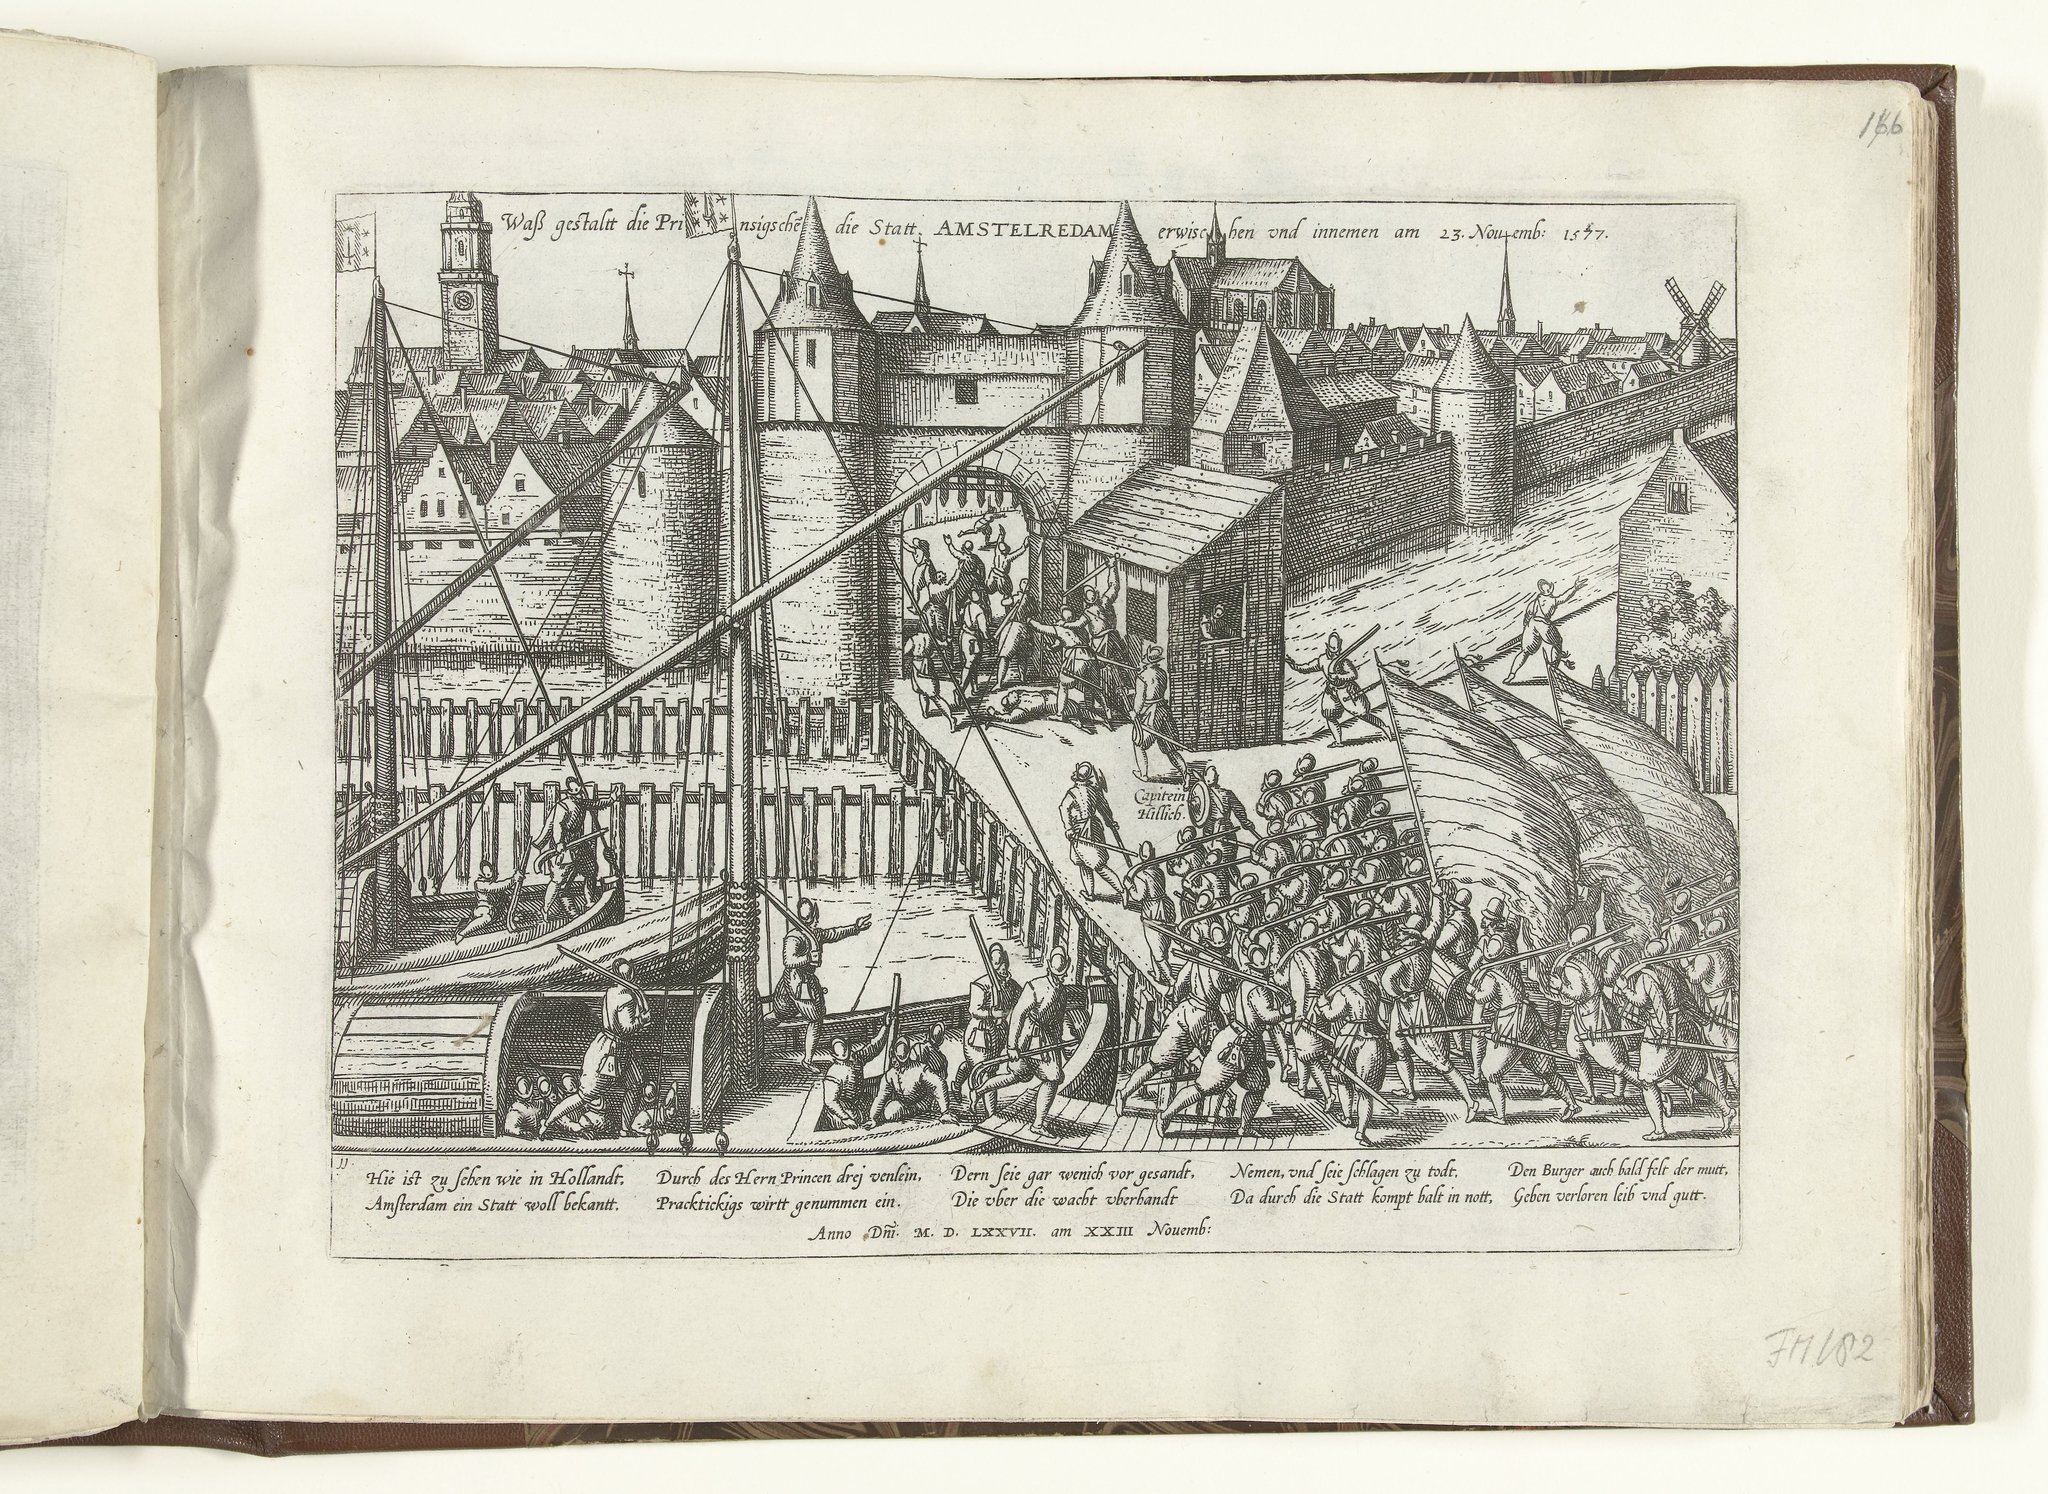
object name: print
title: Serie 8: Nederlandse Gebeurtenissen, 1577-1583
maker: frans hogenberg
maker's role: print maker, publisher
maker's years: 1538-1590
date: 1577-1579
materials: paper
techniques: etching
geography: cologne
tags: haarlem, amsterdam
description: Poging van het Staatse leger onder bevel van Helling en Ruychaver om Amsterdam in te nemen, 23 november 1577. Soldaten komen uit schepen te voorschijn bij de Haarlemmerpoort. Met onderschrift van 12 regels in het Duits. Genummerd: 11.